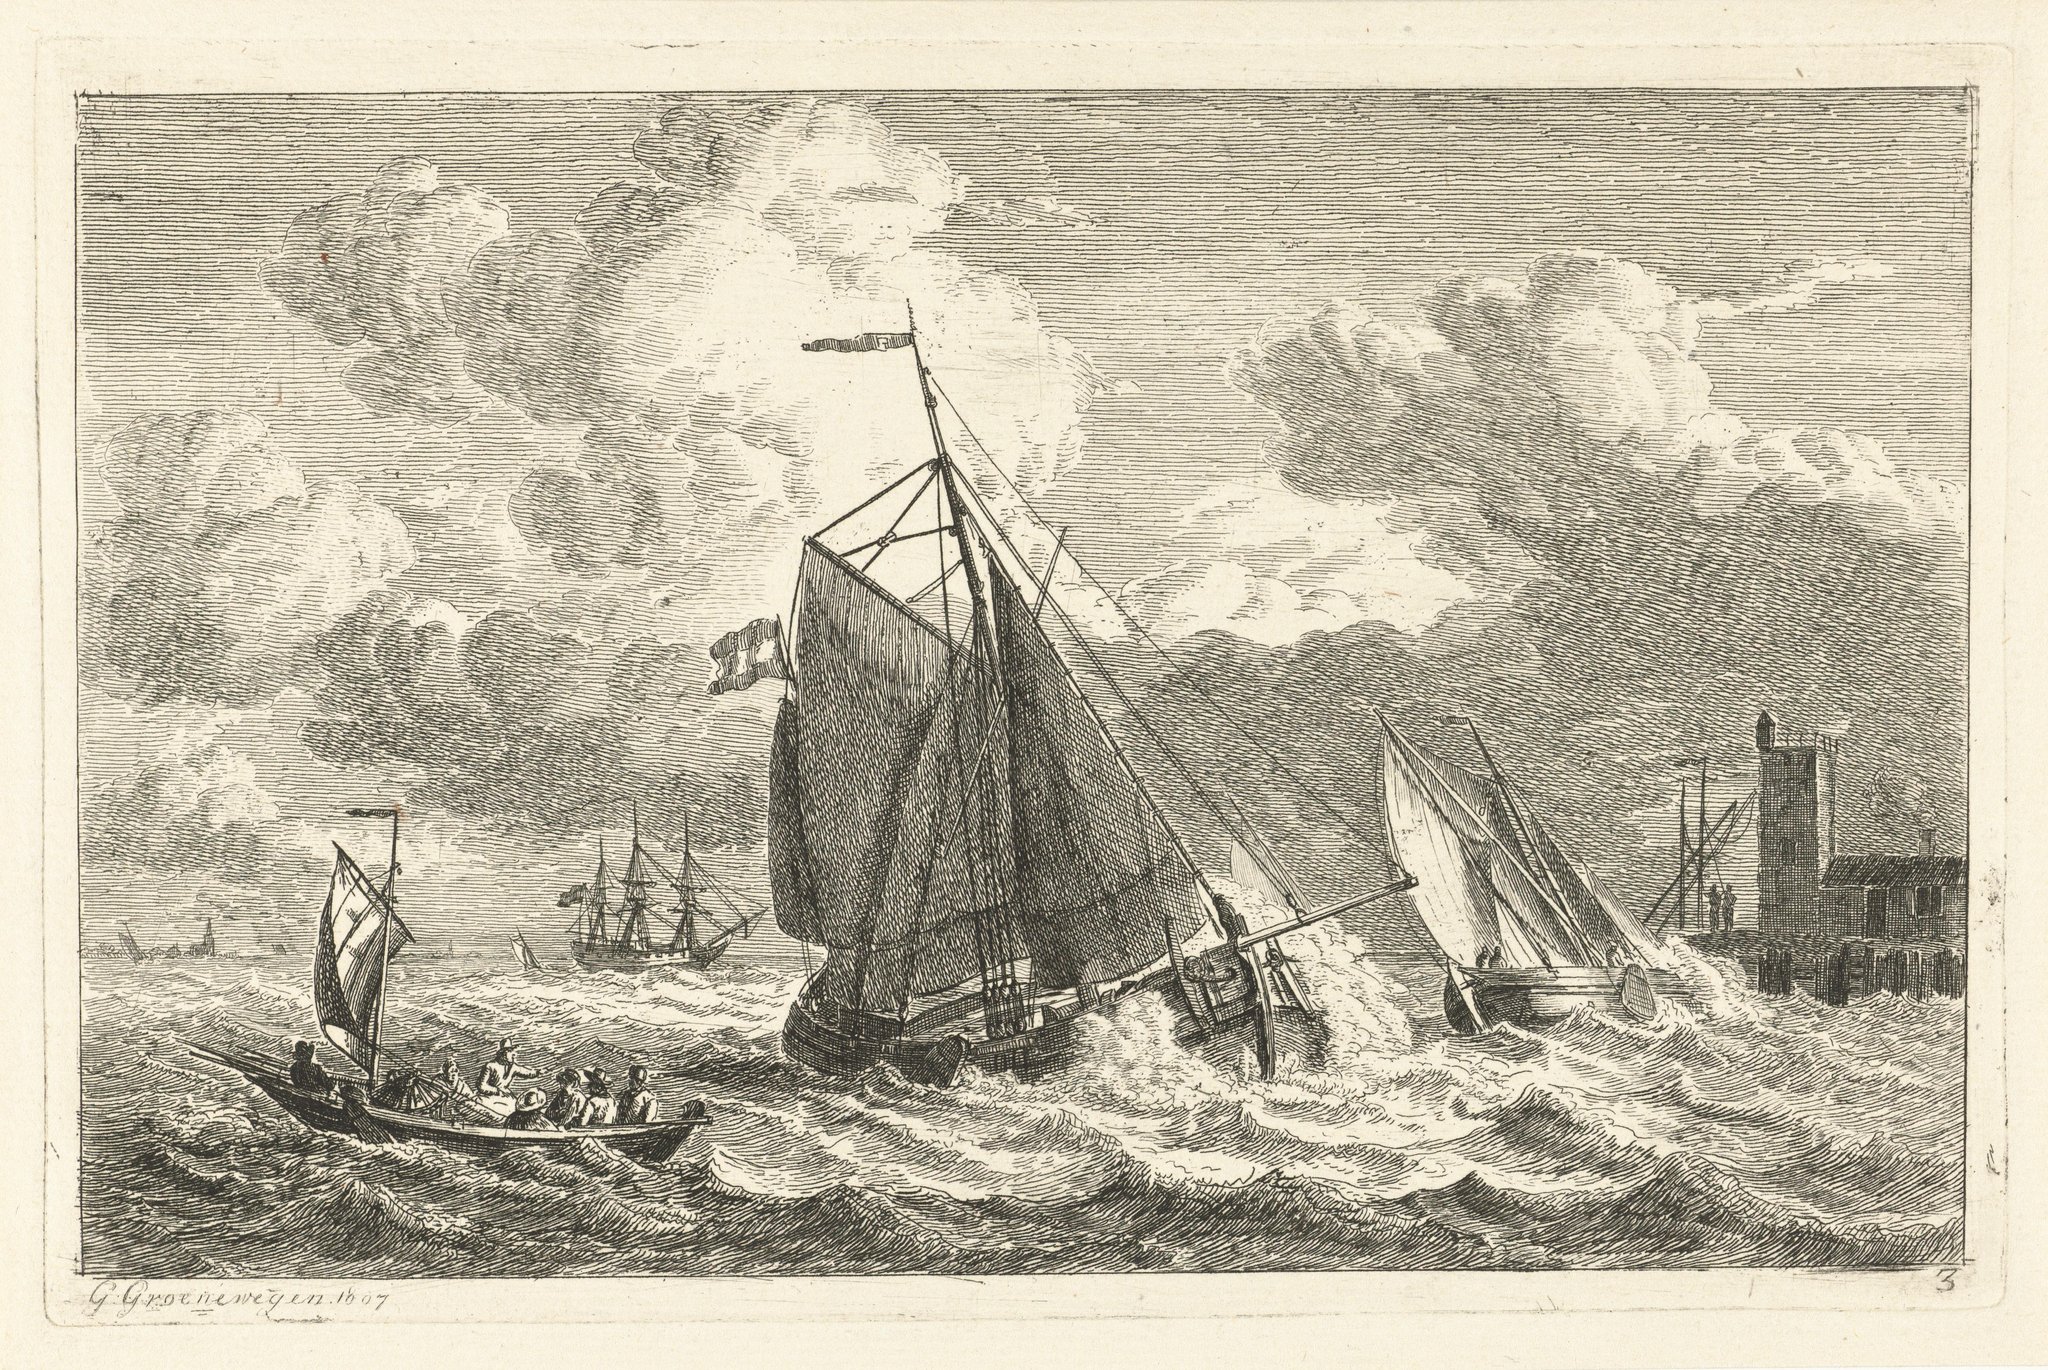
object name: print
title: Diverse schepen op woelig water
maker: gerrit groenewegen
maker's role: draughtsman, print maker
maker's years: 1754-1826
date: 1807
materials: paper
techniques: etching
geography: rotterdam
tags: ships (in general) - cc - more than one ship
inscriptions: collector's mark: Lugt 2228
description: Diverse zeilschepen op woelig water. Aan de rechterzijde een huis met een toren waar twee figuren naast staan. Links op de achtergrond de contouren van een kerktoren en andere bebouwing. Deze prent maakt deel uit van een serie van zes prenten met diverse schepen.